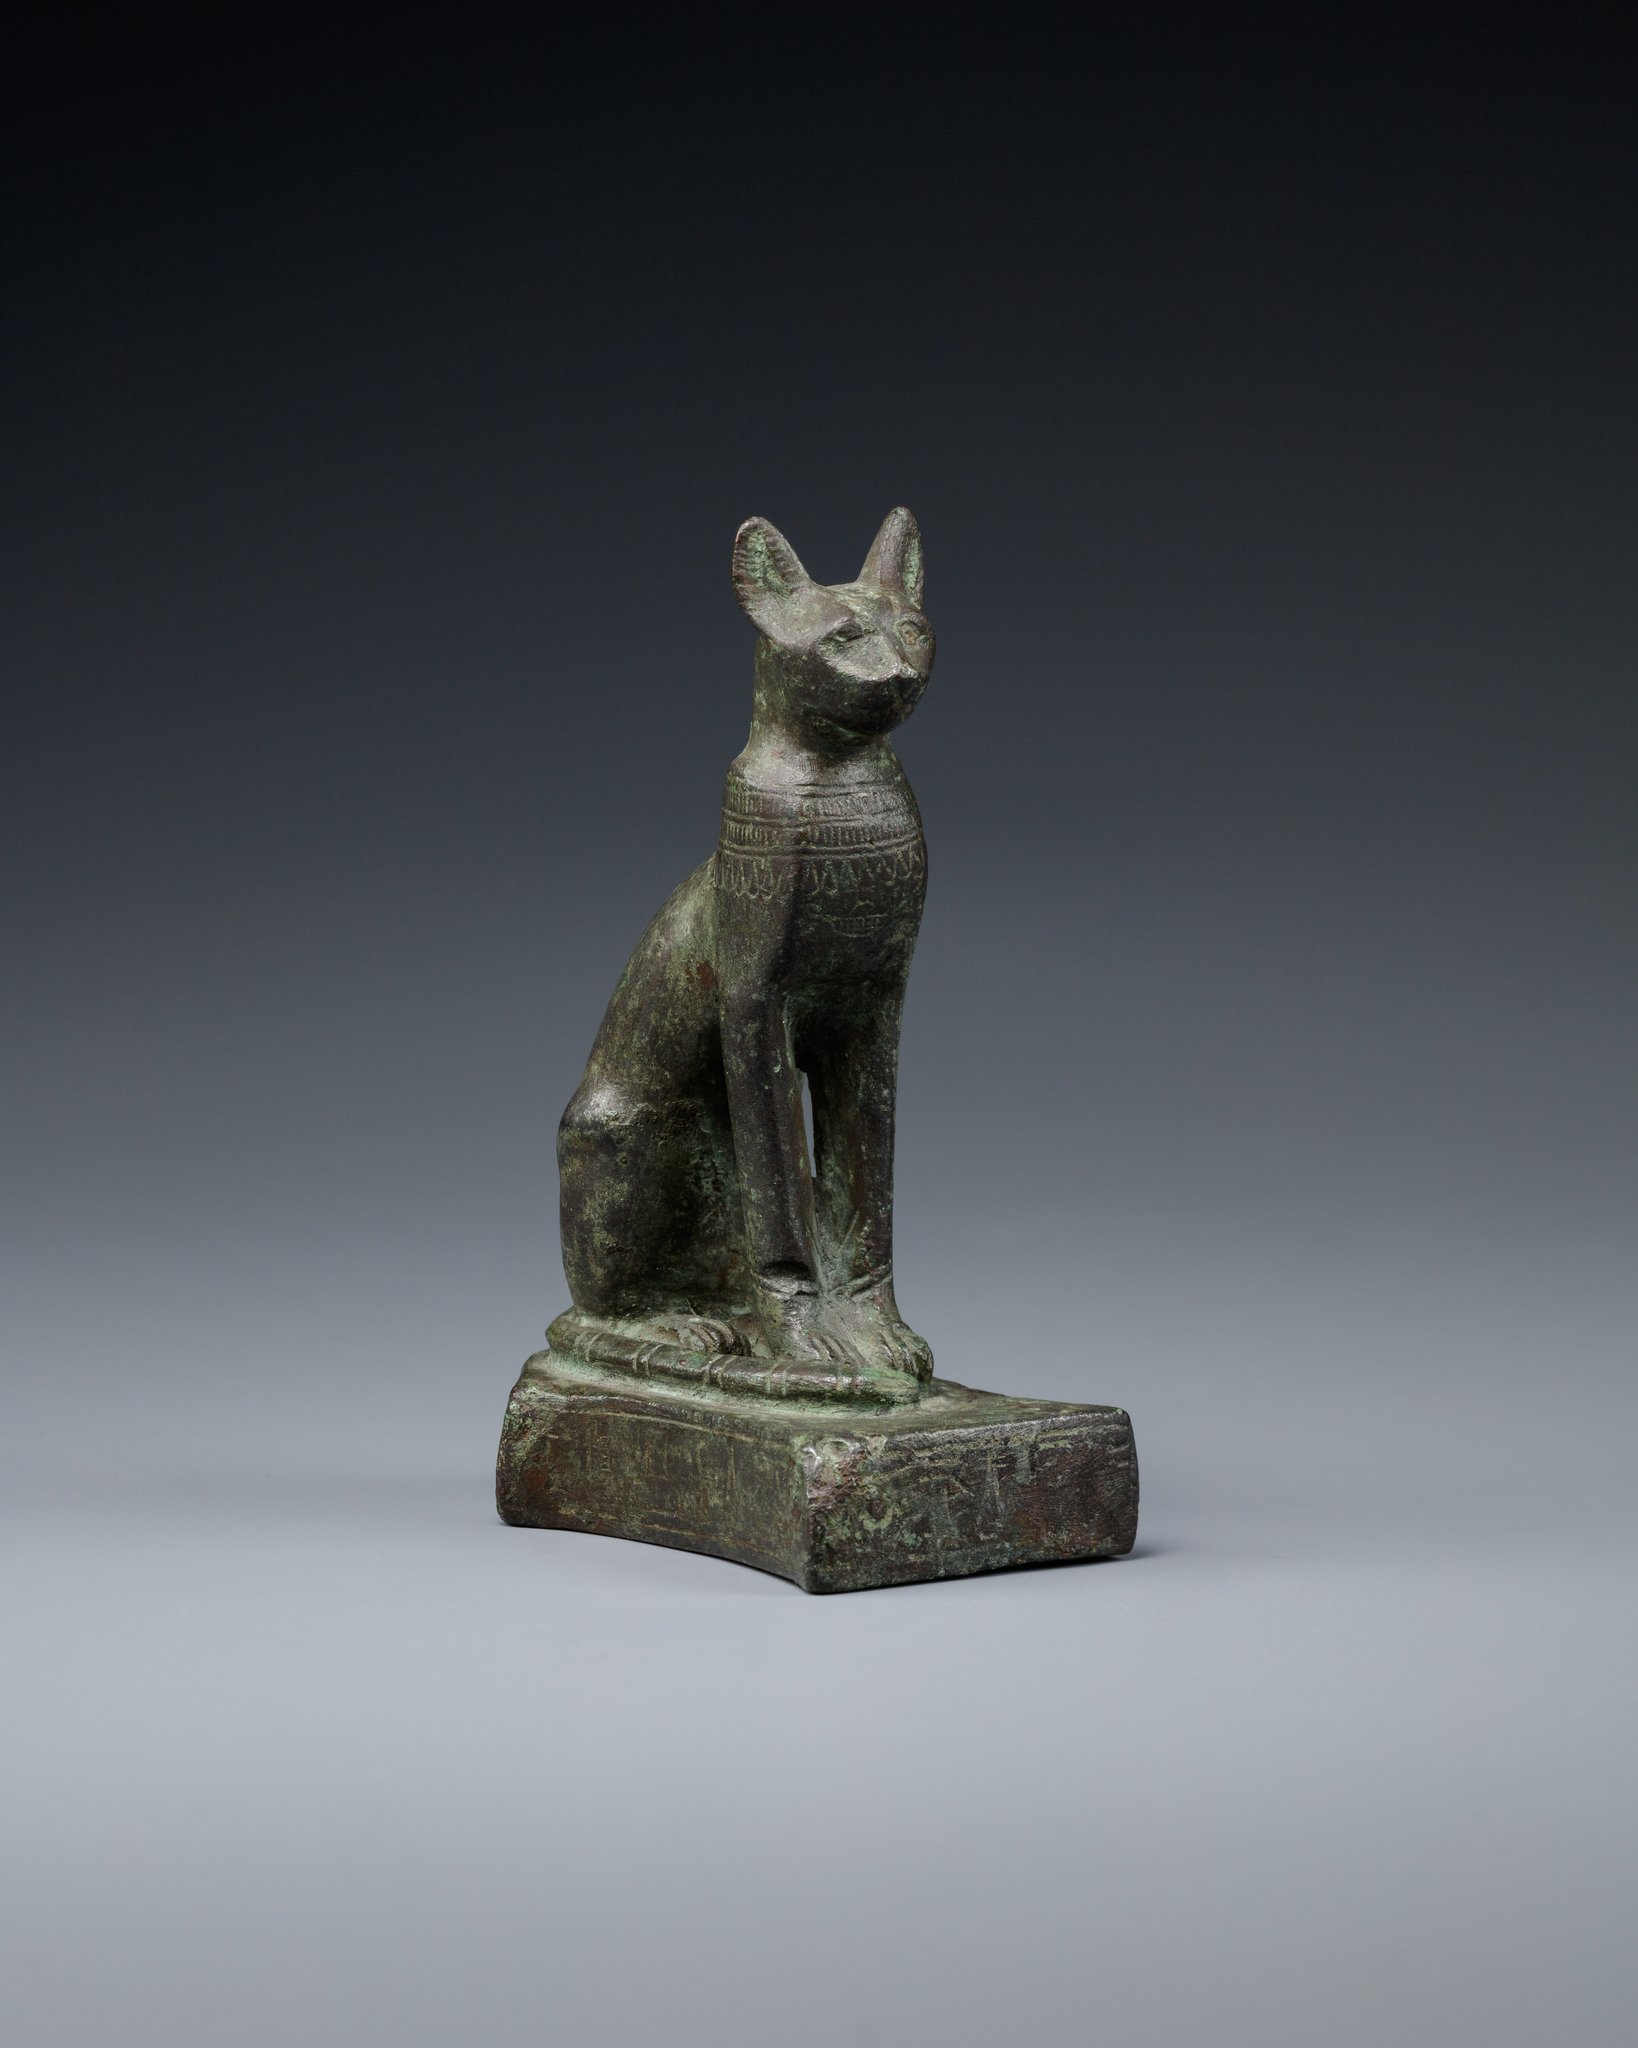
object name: figurine, cat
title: Cat with very worn inscription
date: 664-630 BCE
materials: metal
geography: egypt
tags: cats